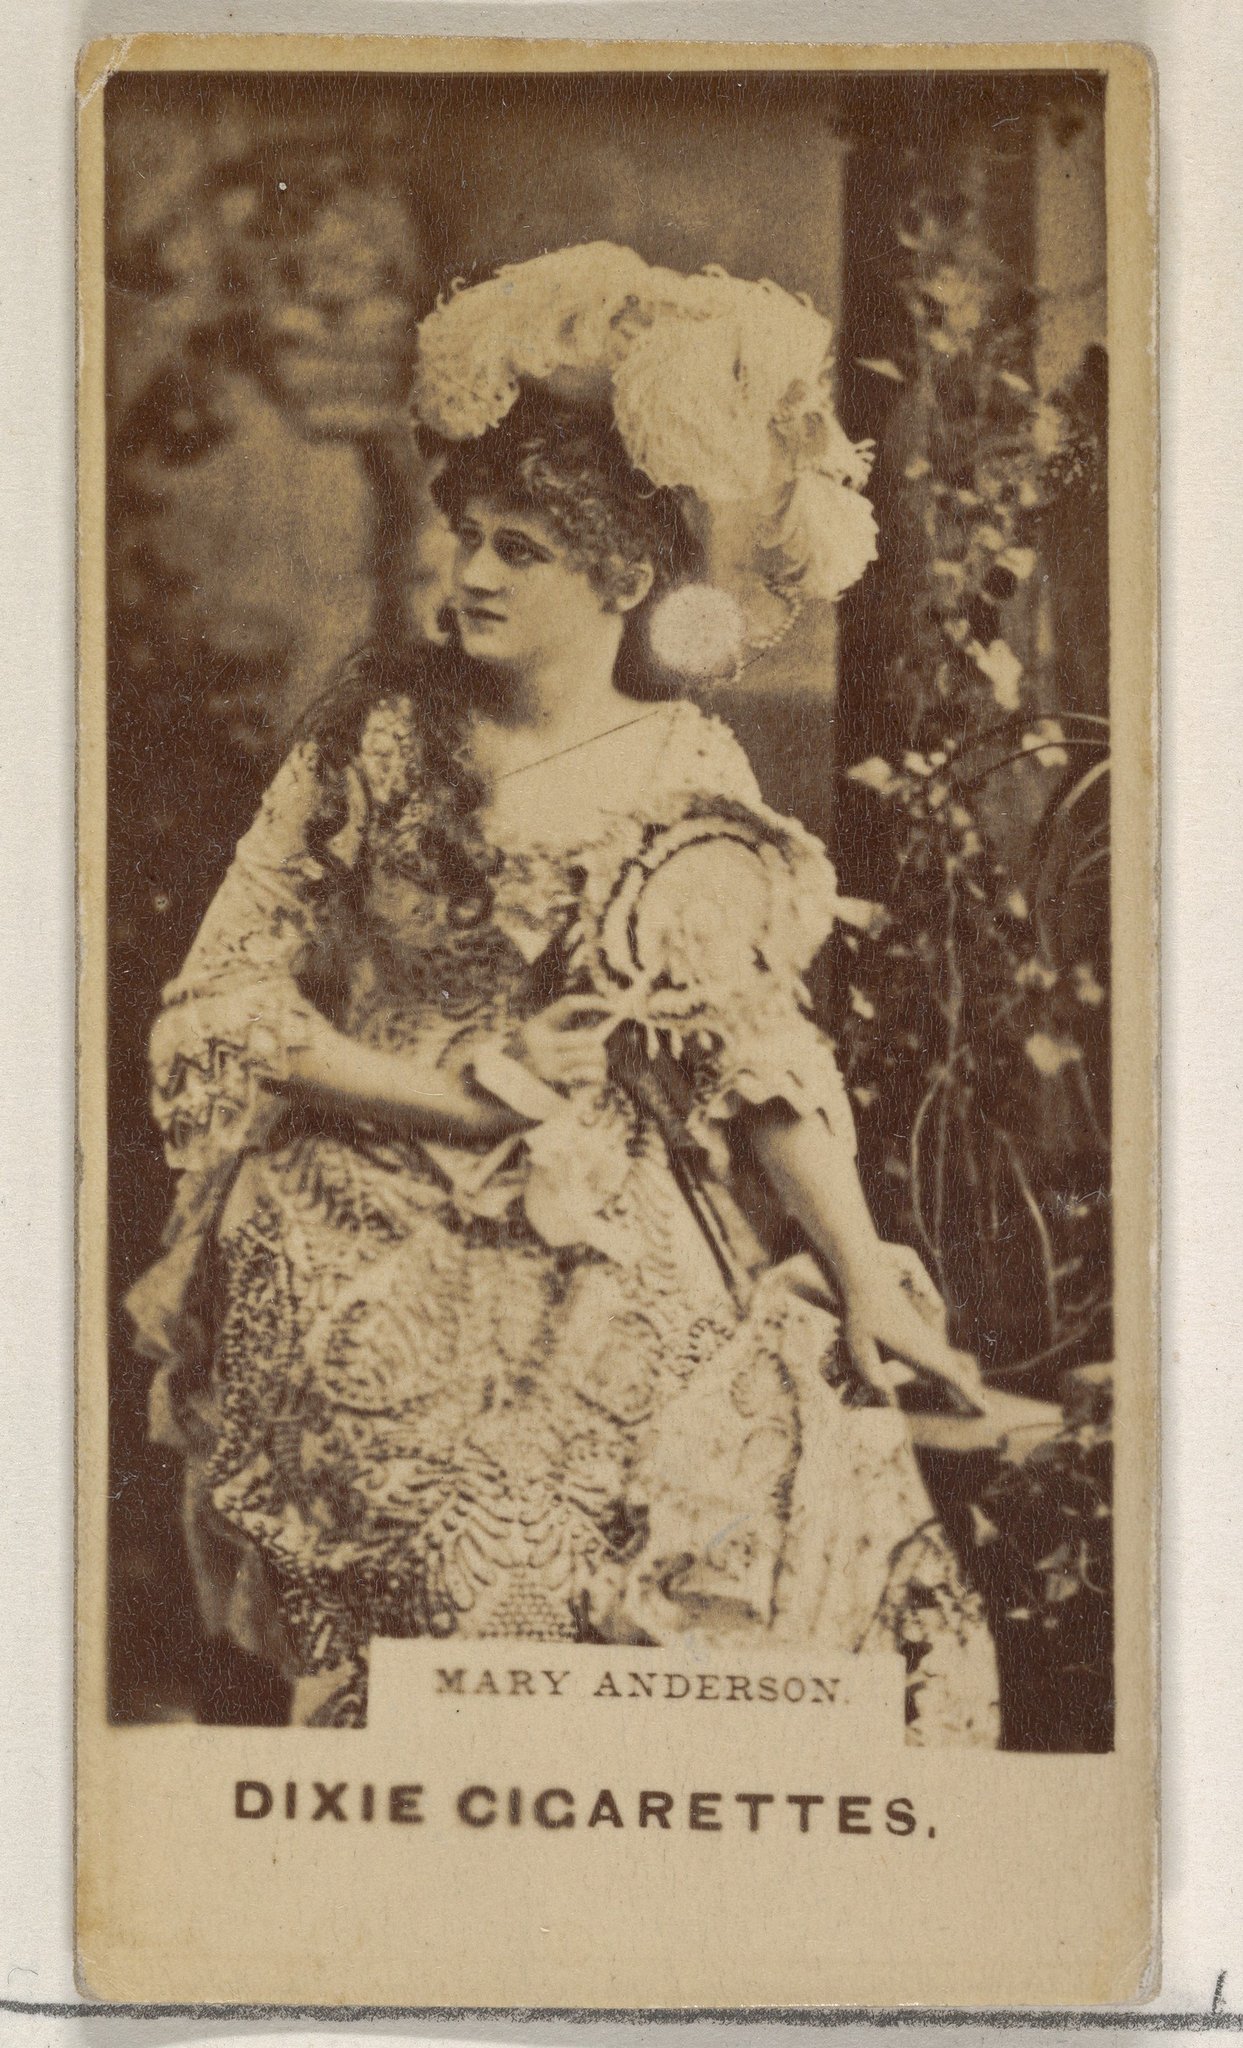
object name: photograph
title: Mary Anderson, from the Actors and Actresses series (N45, Type 7) for Dixie Cigarettes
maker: allen & ginter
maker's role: publisher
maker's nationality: american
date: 1888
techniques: albumen silver print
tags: portraits,women,actresses